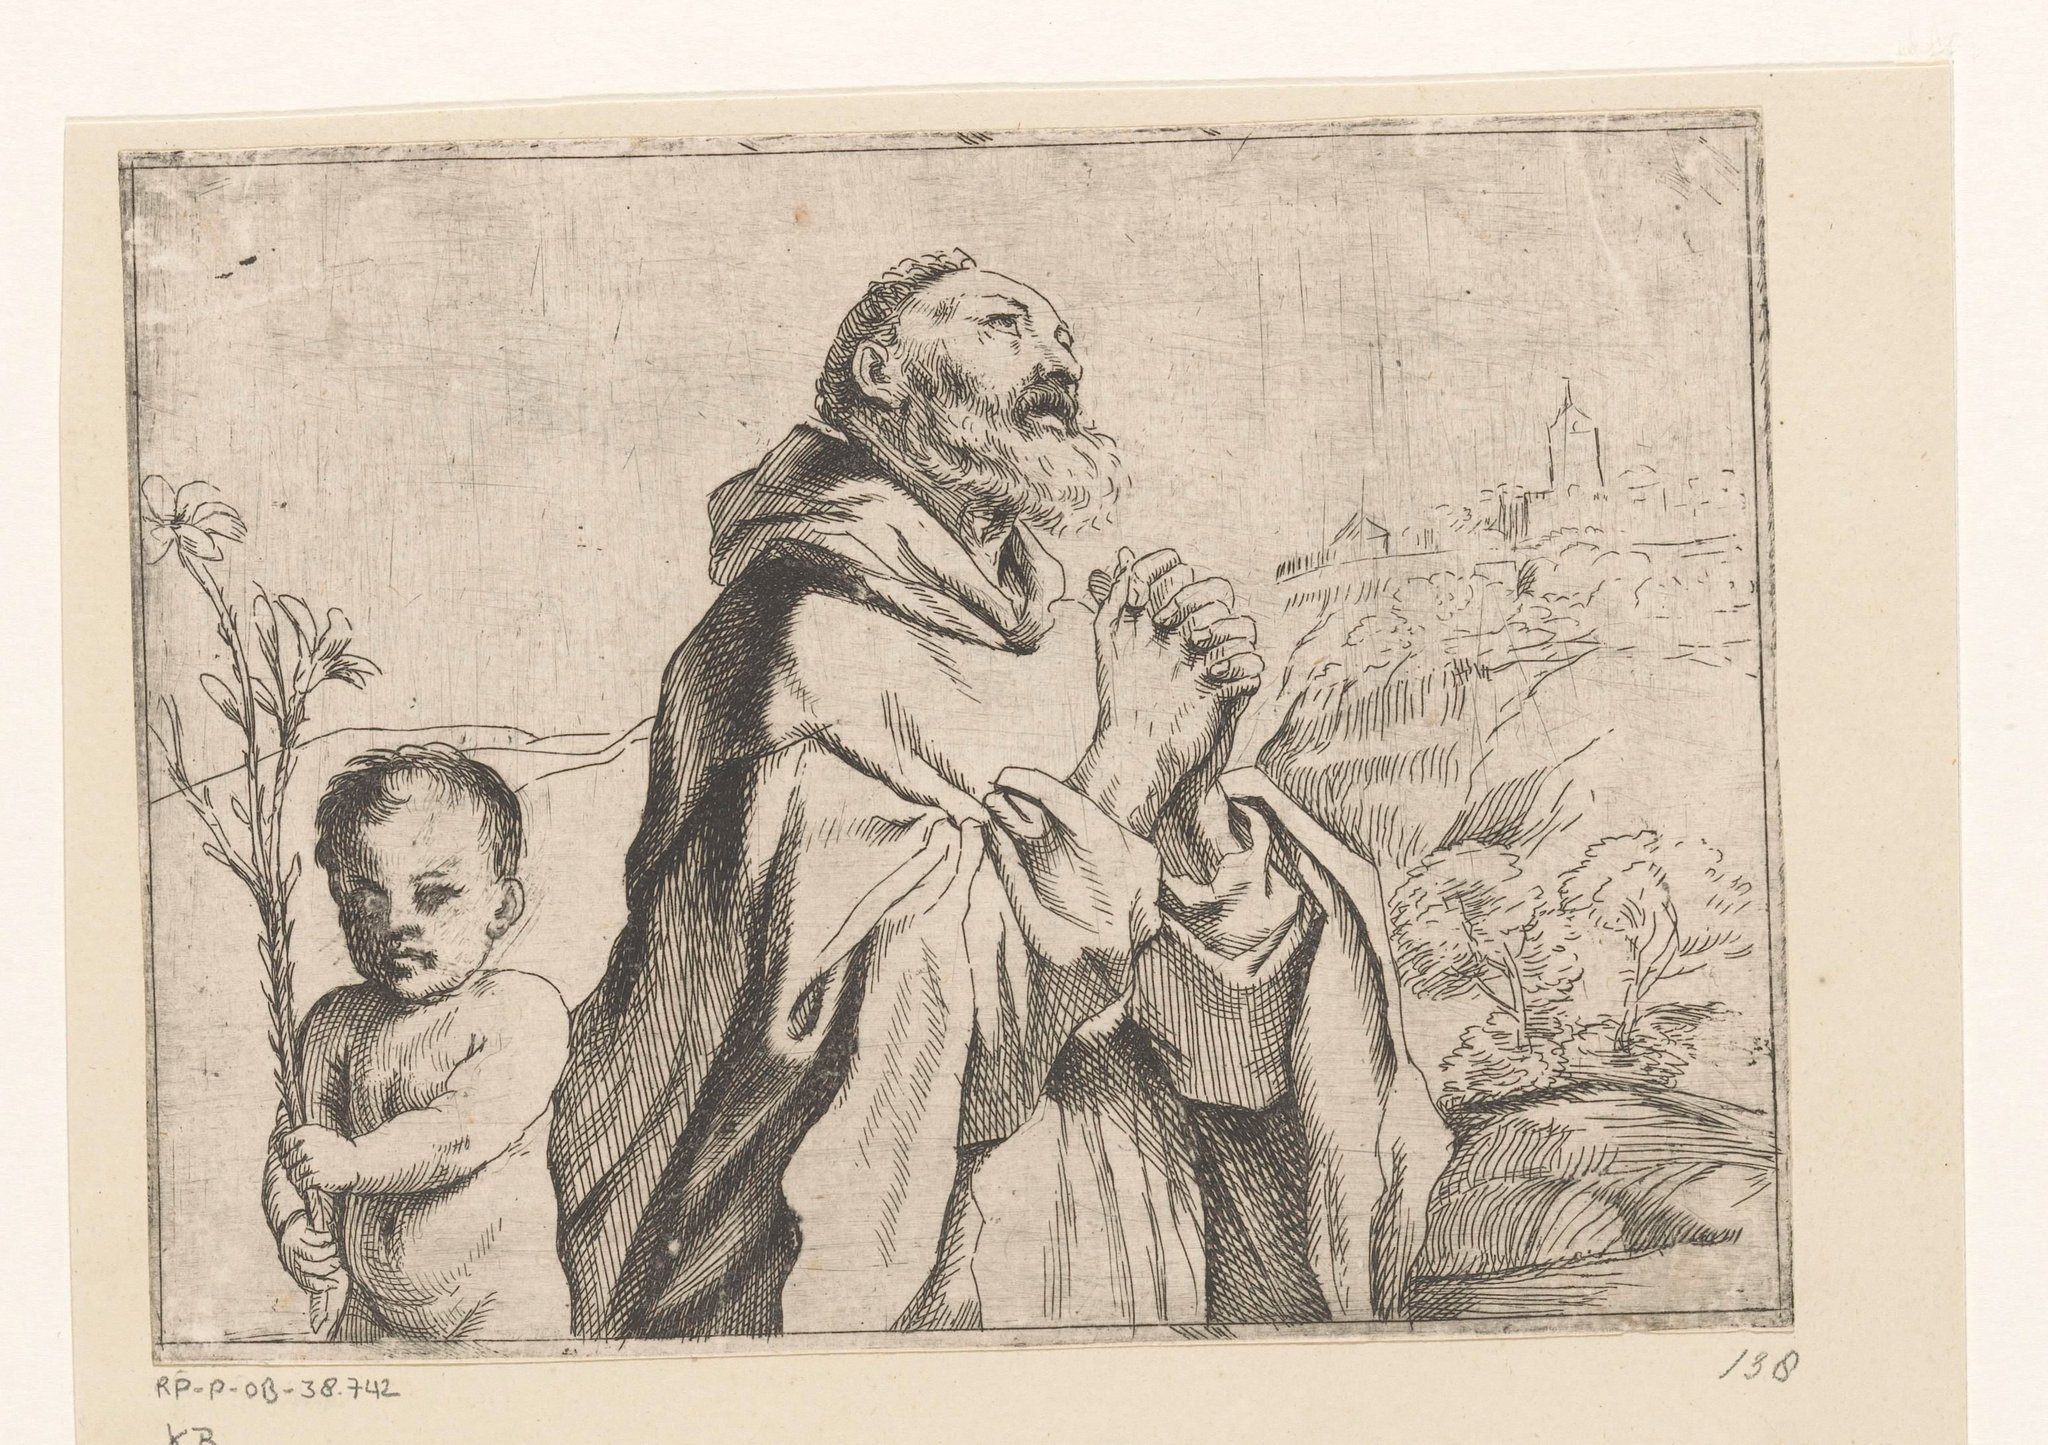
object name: print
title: Heilige Dominicus met een kind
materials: paper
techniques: etching, intaglio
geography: italy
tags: city-view, and landscape with man-made constructions, dominic(us) guzman of calerueja, founder of the order of preachers (or dominican (black) friars; possible attributes: book, dog with flaming torch, lily, loaf of bread, rosary, star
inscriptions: collector's mark: Lugt 240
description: De heilige Dominicus in gebed. Links staat een kind met een tak met lelies in de hand. Rechts op de achtergrond een landschap.